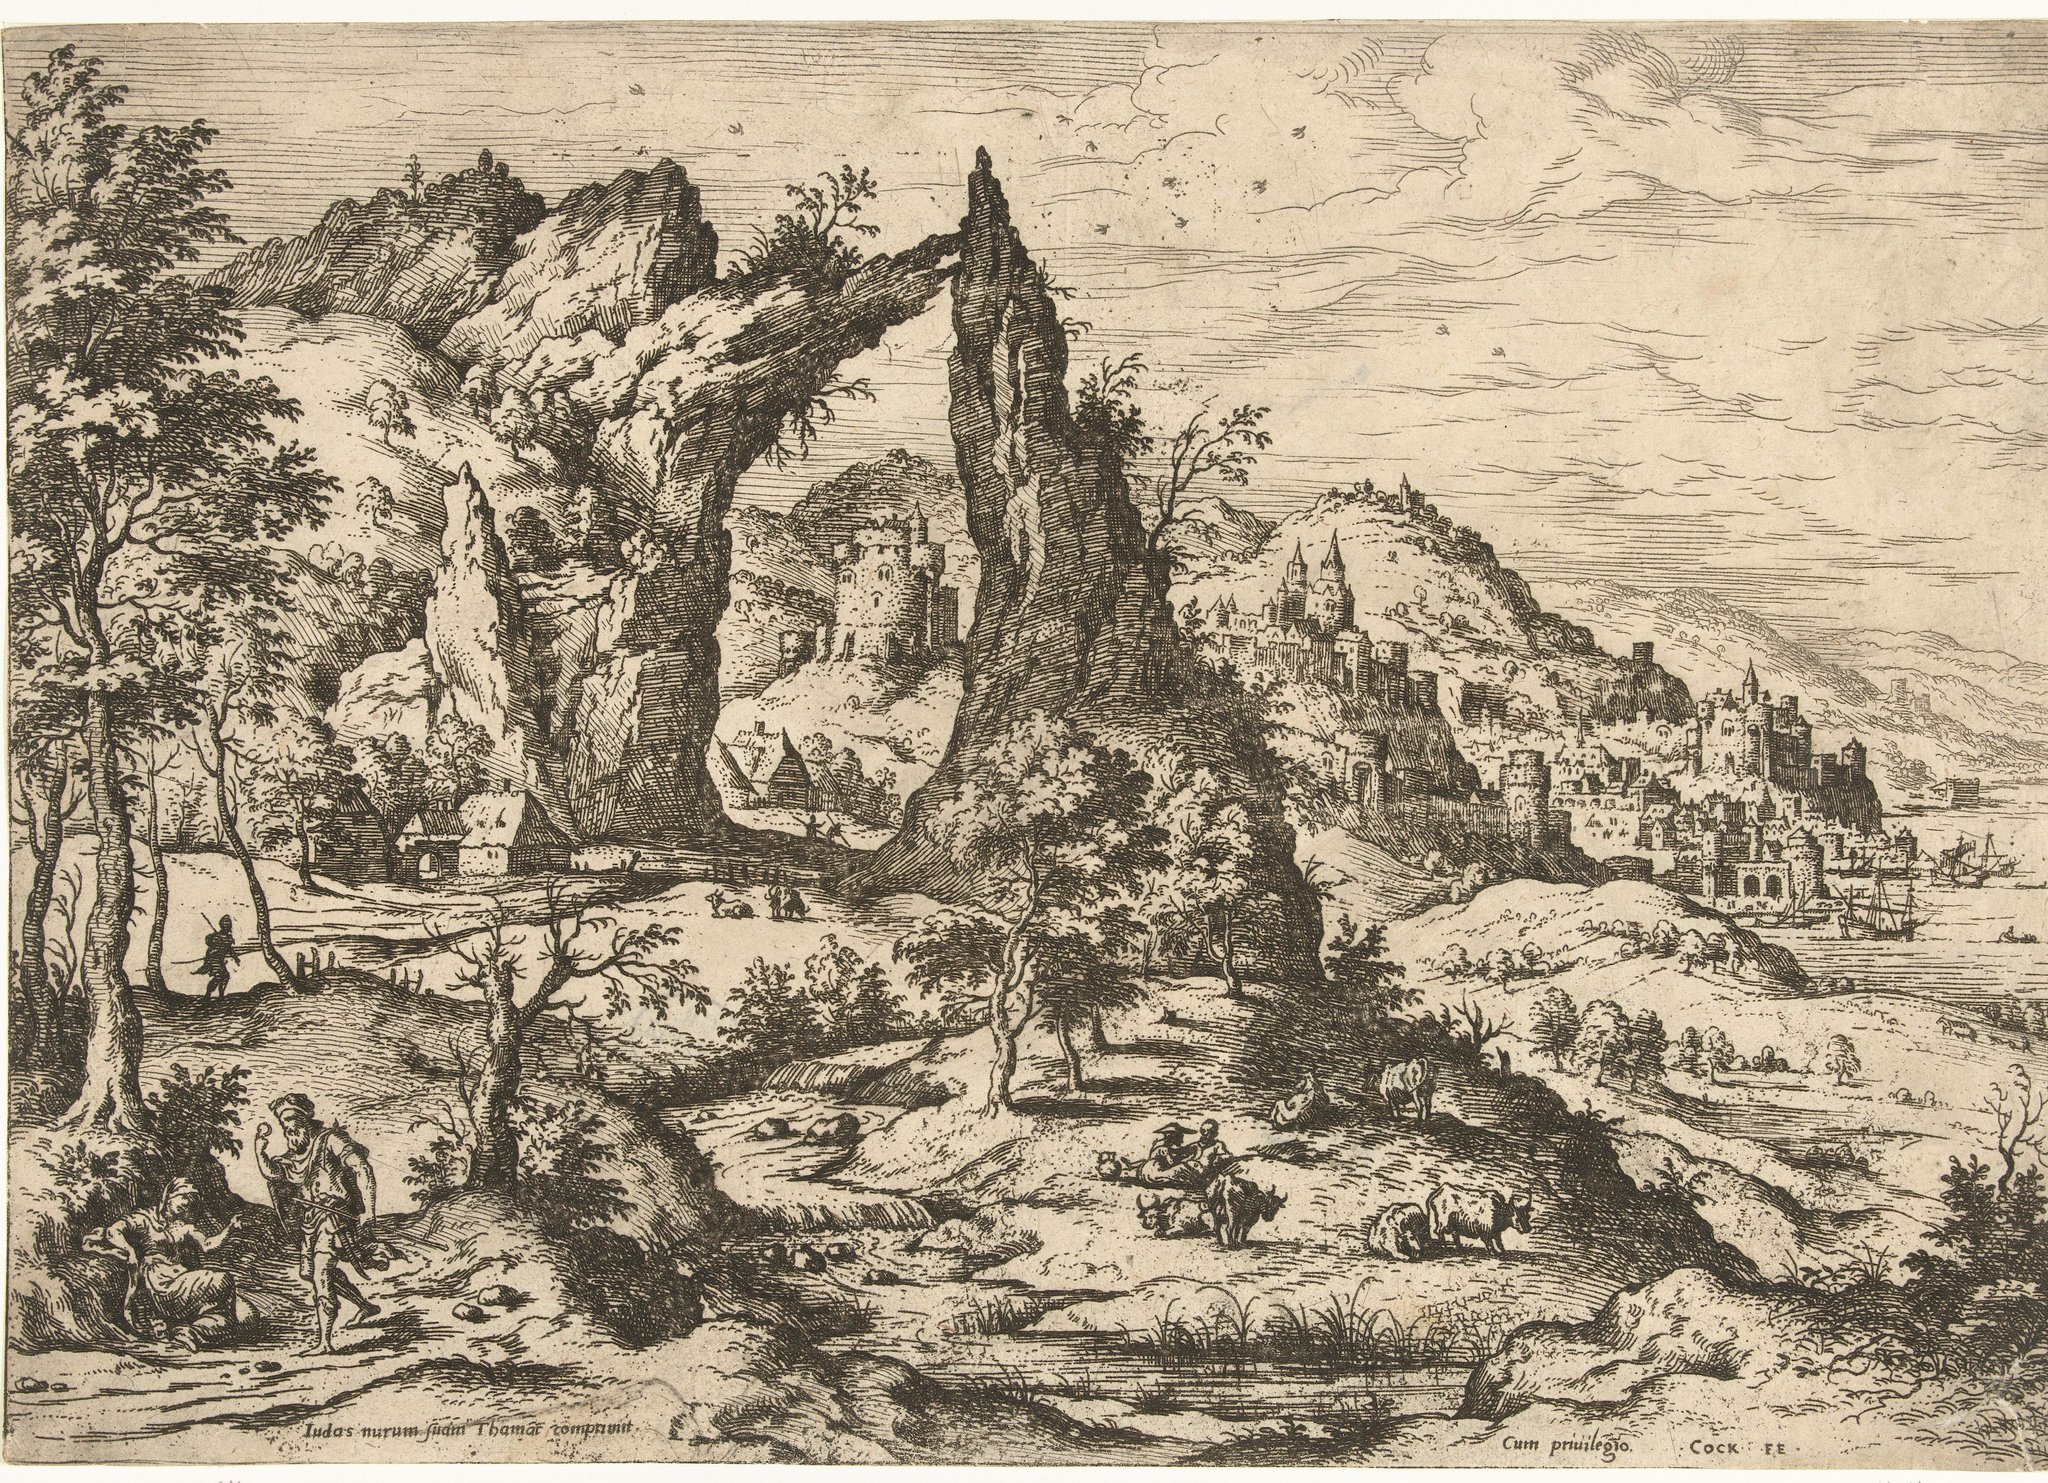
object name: print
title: Landschappen met bijbelse en mythologische scènes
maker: hieronymus cock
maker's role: print maker, publisher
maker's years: 1518-1570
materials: paper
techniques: etching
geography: antwerp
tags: story of judah and tamar (genesis 38), tamar changes from her widow's clothes and covers her face with a veil after the manner of the prostitutes; sitting at the entrance of a city on the road to timnath she awaits judah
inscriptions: collector's mark: Lugt 1672, collector's mark: Lugt 2398, collector's mark: Lugt 1606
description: Bergachtig landschap met rechts een havenstad. Links op een weg Tamar en Juda. Door zich als hoer te verkleden, verleidt Tamar haar schoonvader Juda. Tamar raakt zwanger en kan door middel van een ring die Juda haar heeft gegeven als betaling bewijzen dat hij de vader van haar kind is. Prent uit een serie van 13 landschappen met bijbelse en mythologische scènes.